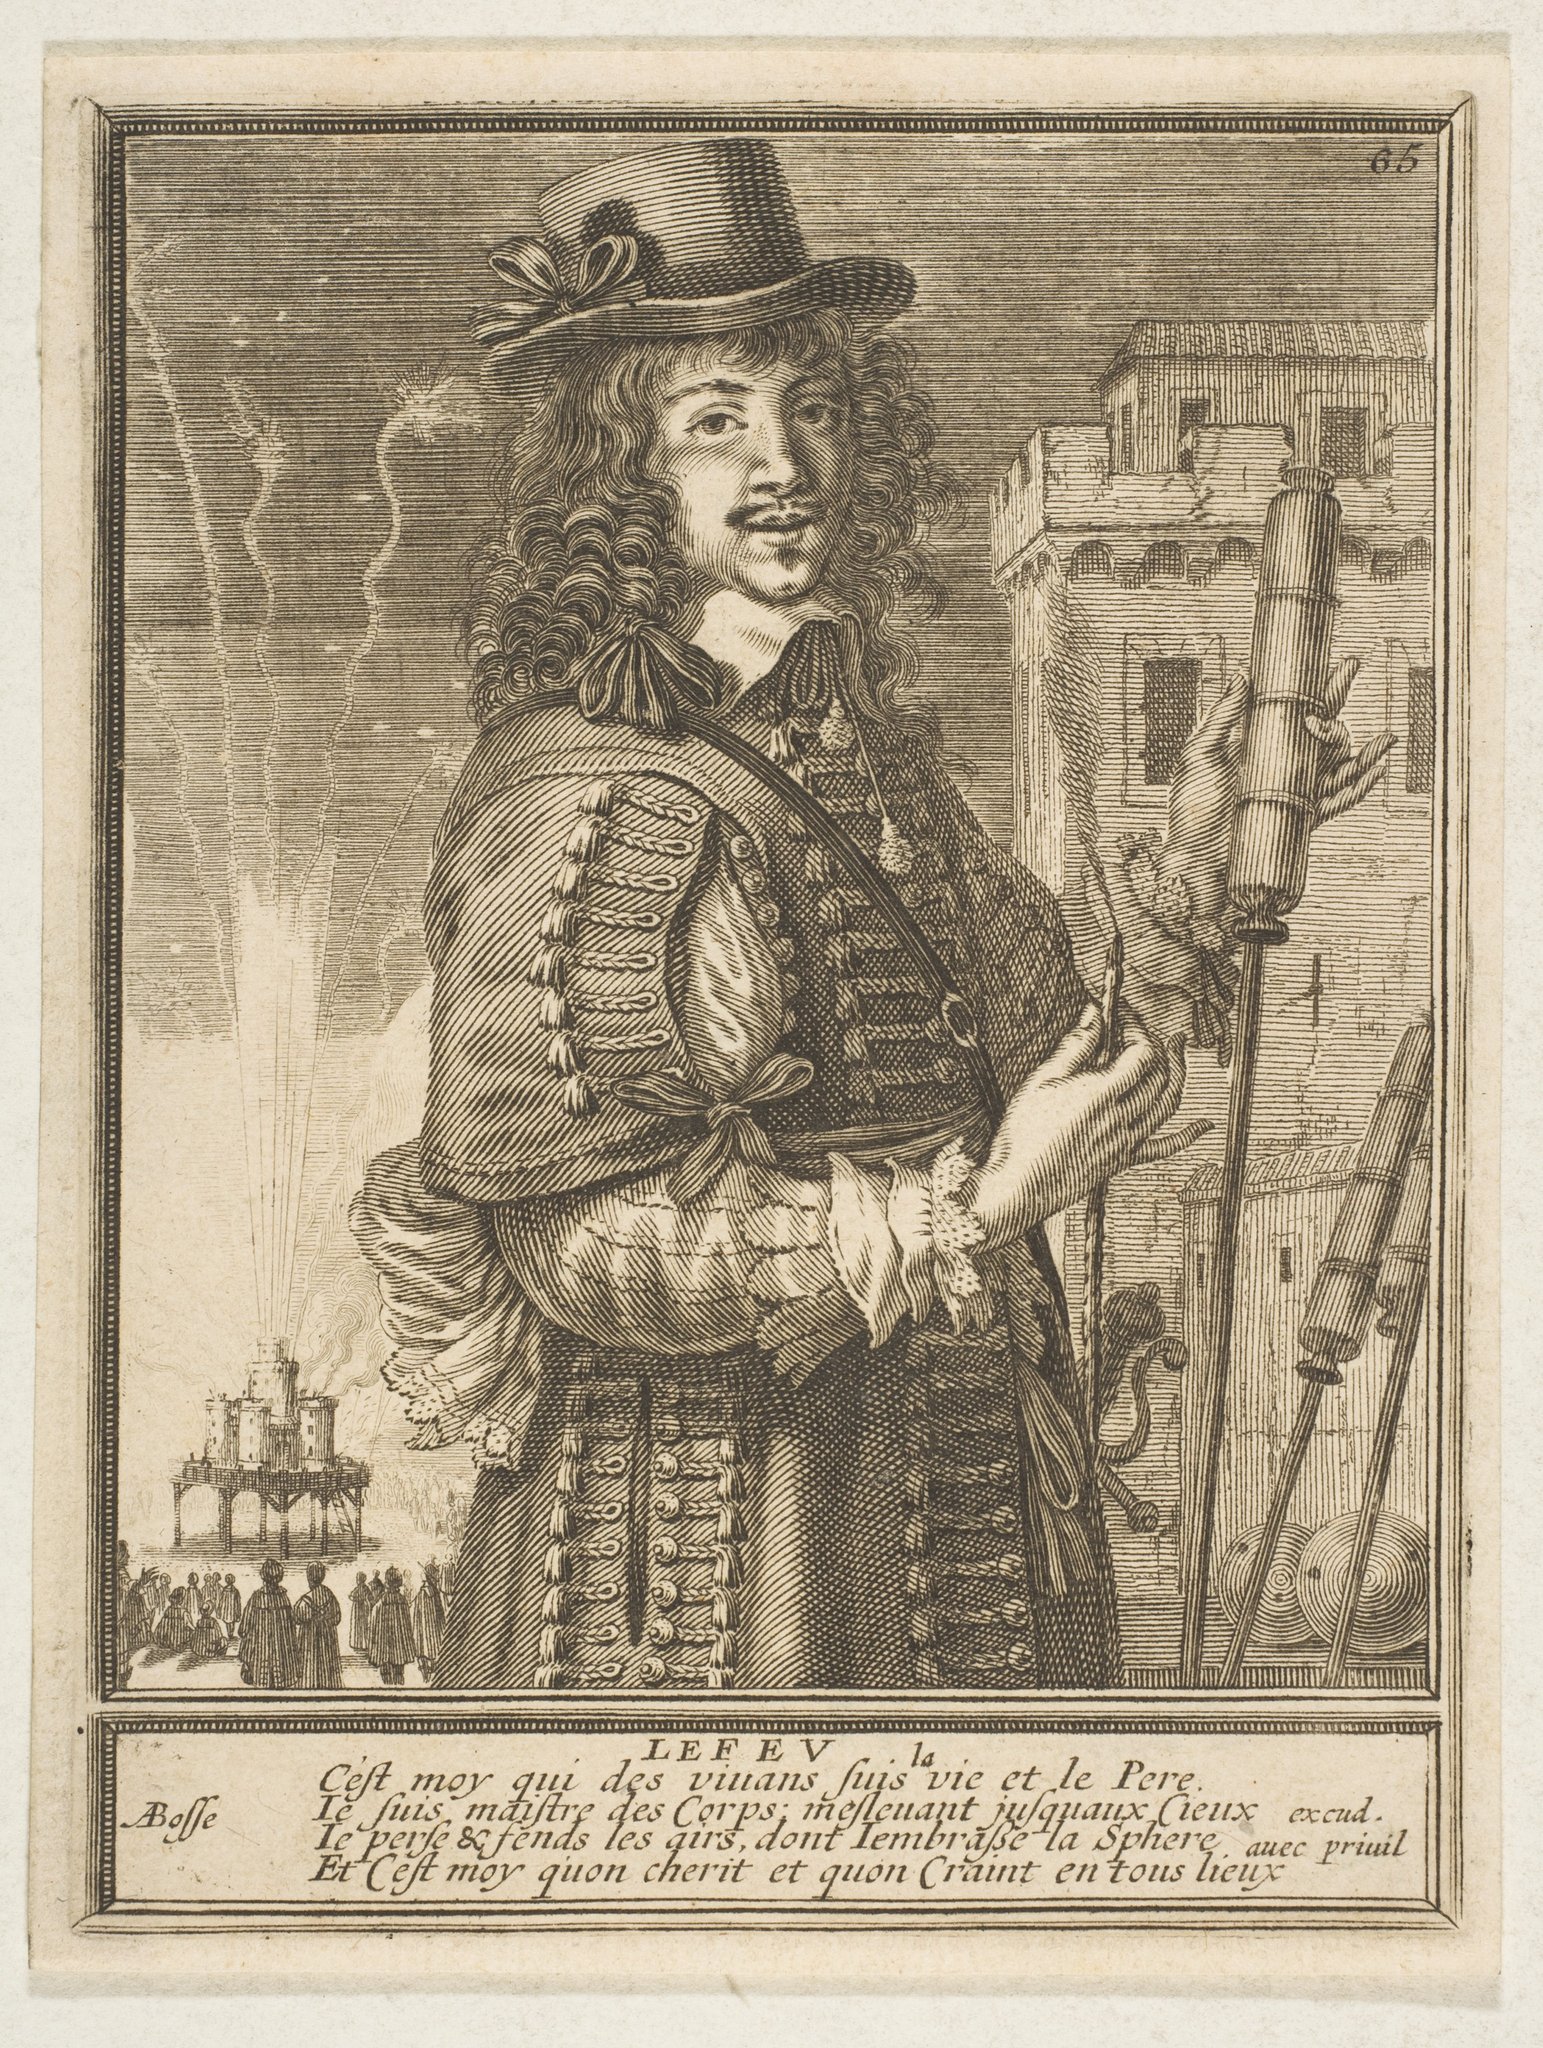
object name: print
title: Fire (Le Feu)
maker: abraham bosse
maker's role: artist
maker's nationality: french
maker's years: 1602-1676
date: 1648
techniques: etching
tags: men,portraits,fireworks